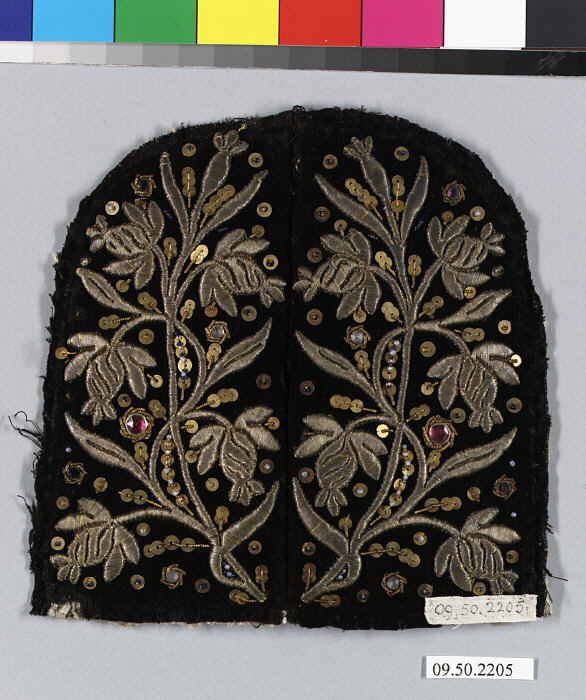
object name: fragment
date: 1801-1833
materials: metal thread, velvet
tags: flowers,leaves